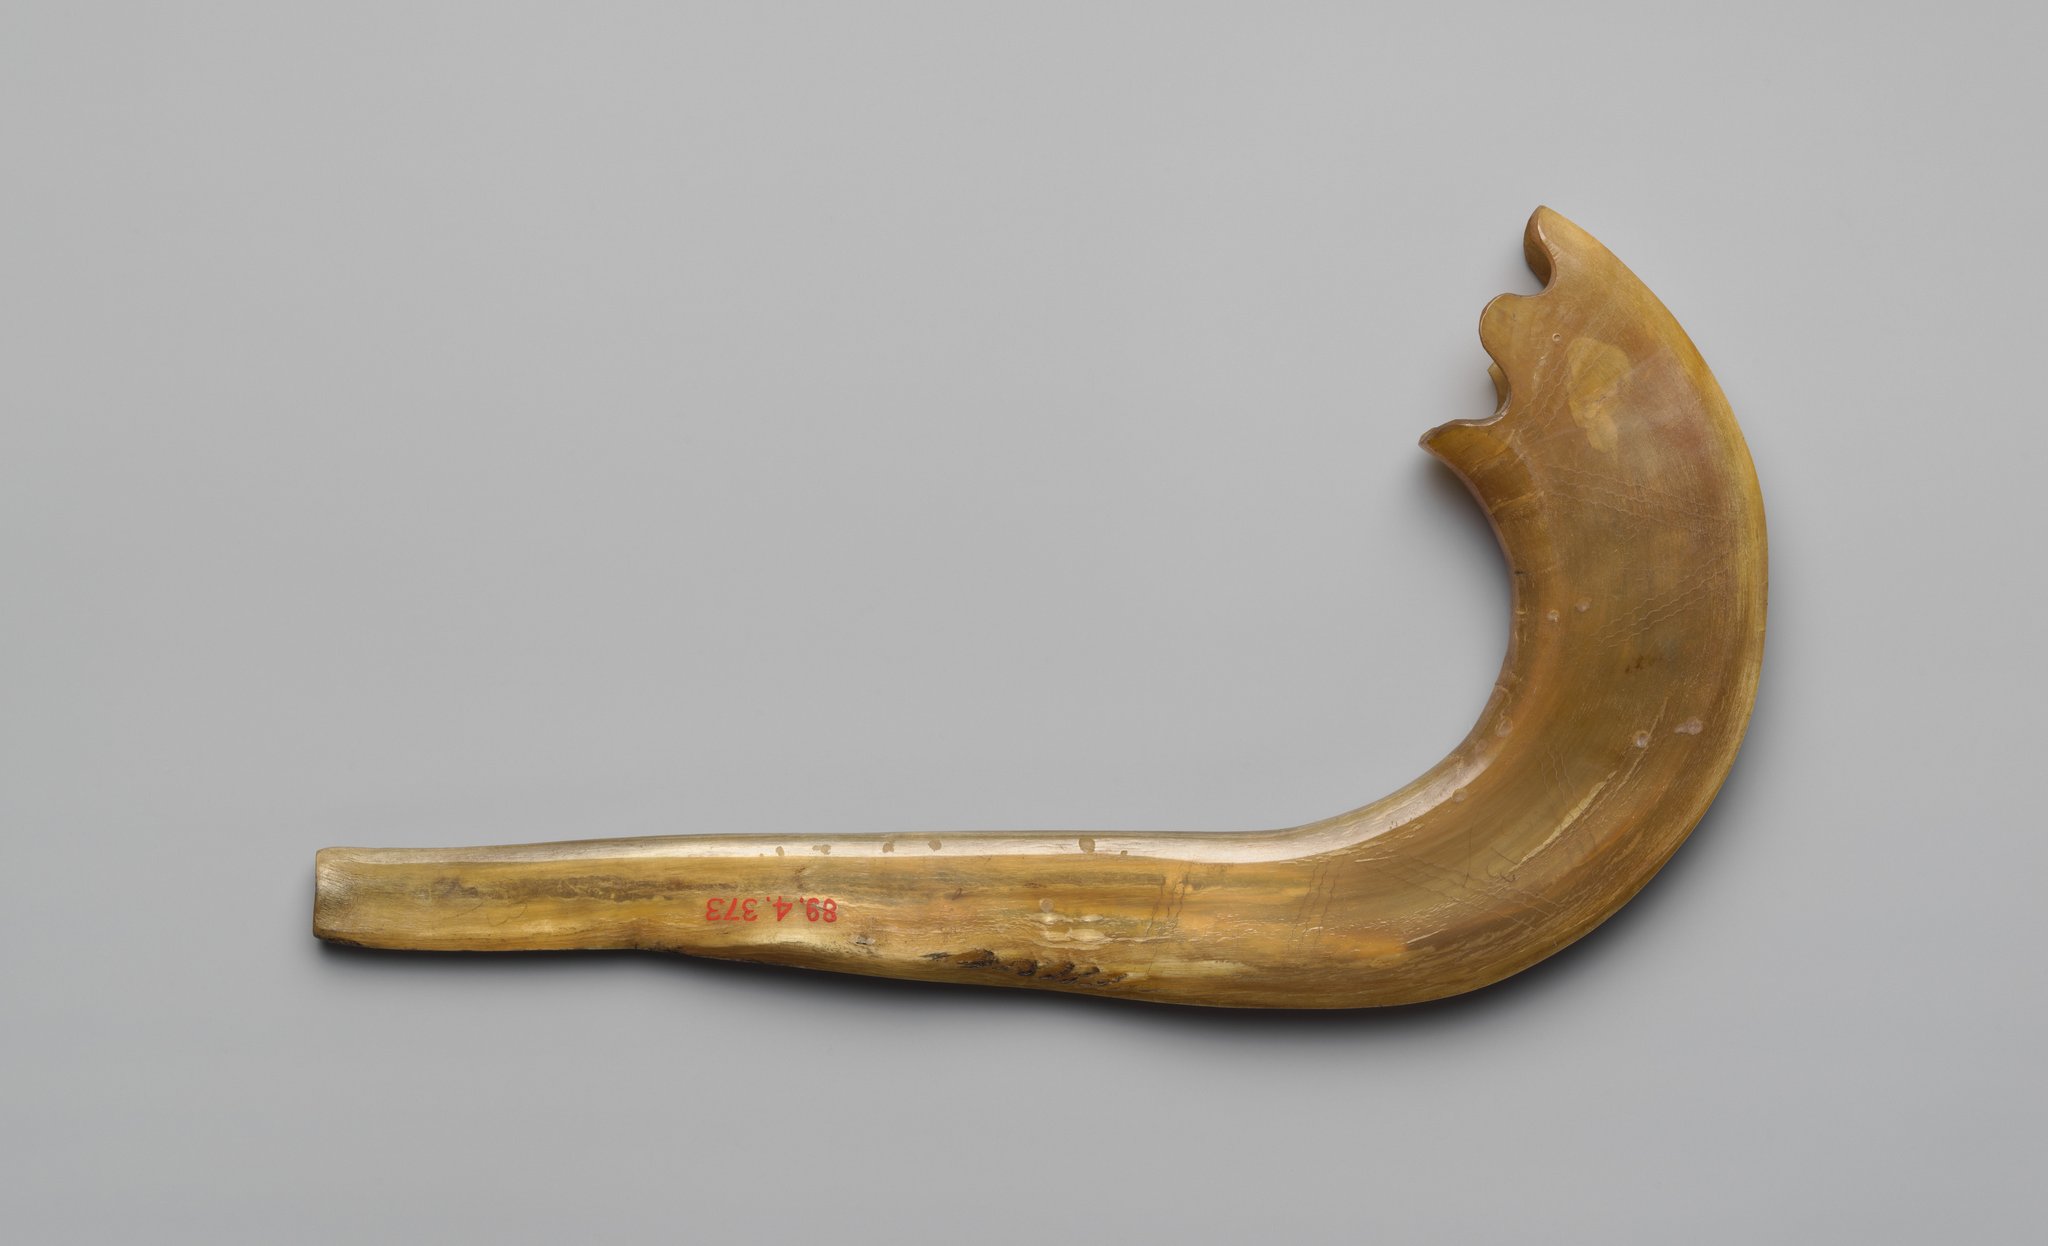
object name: shofar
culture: european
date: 1801-1900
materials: horn